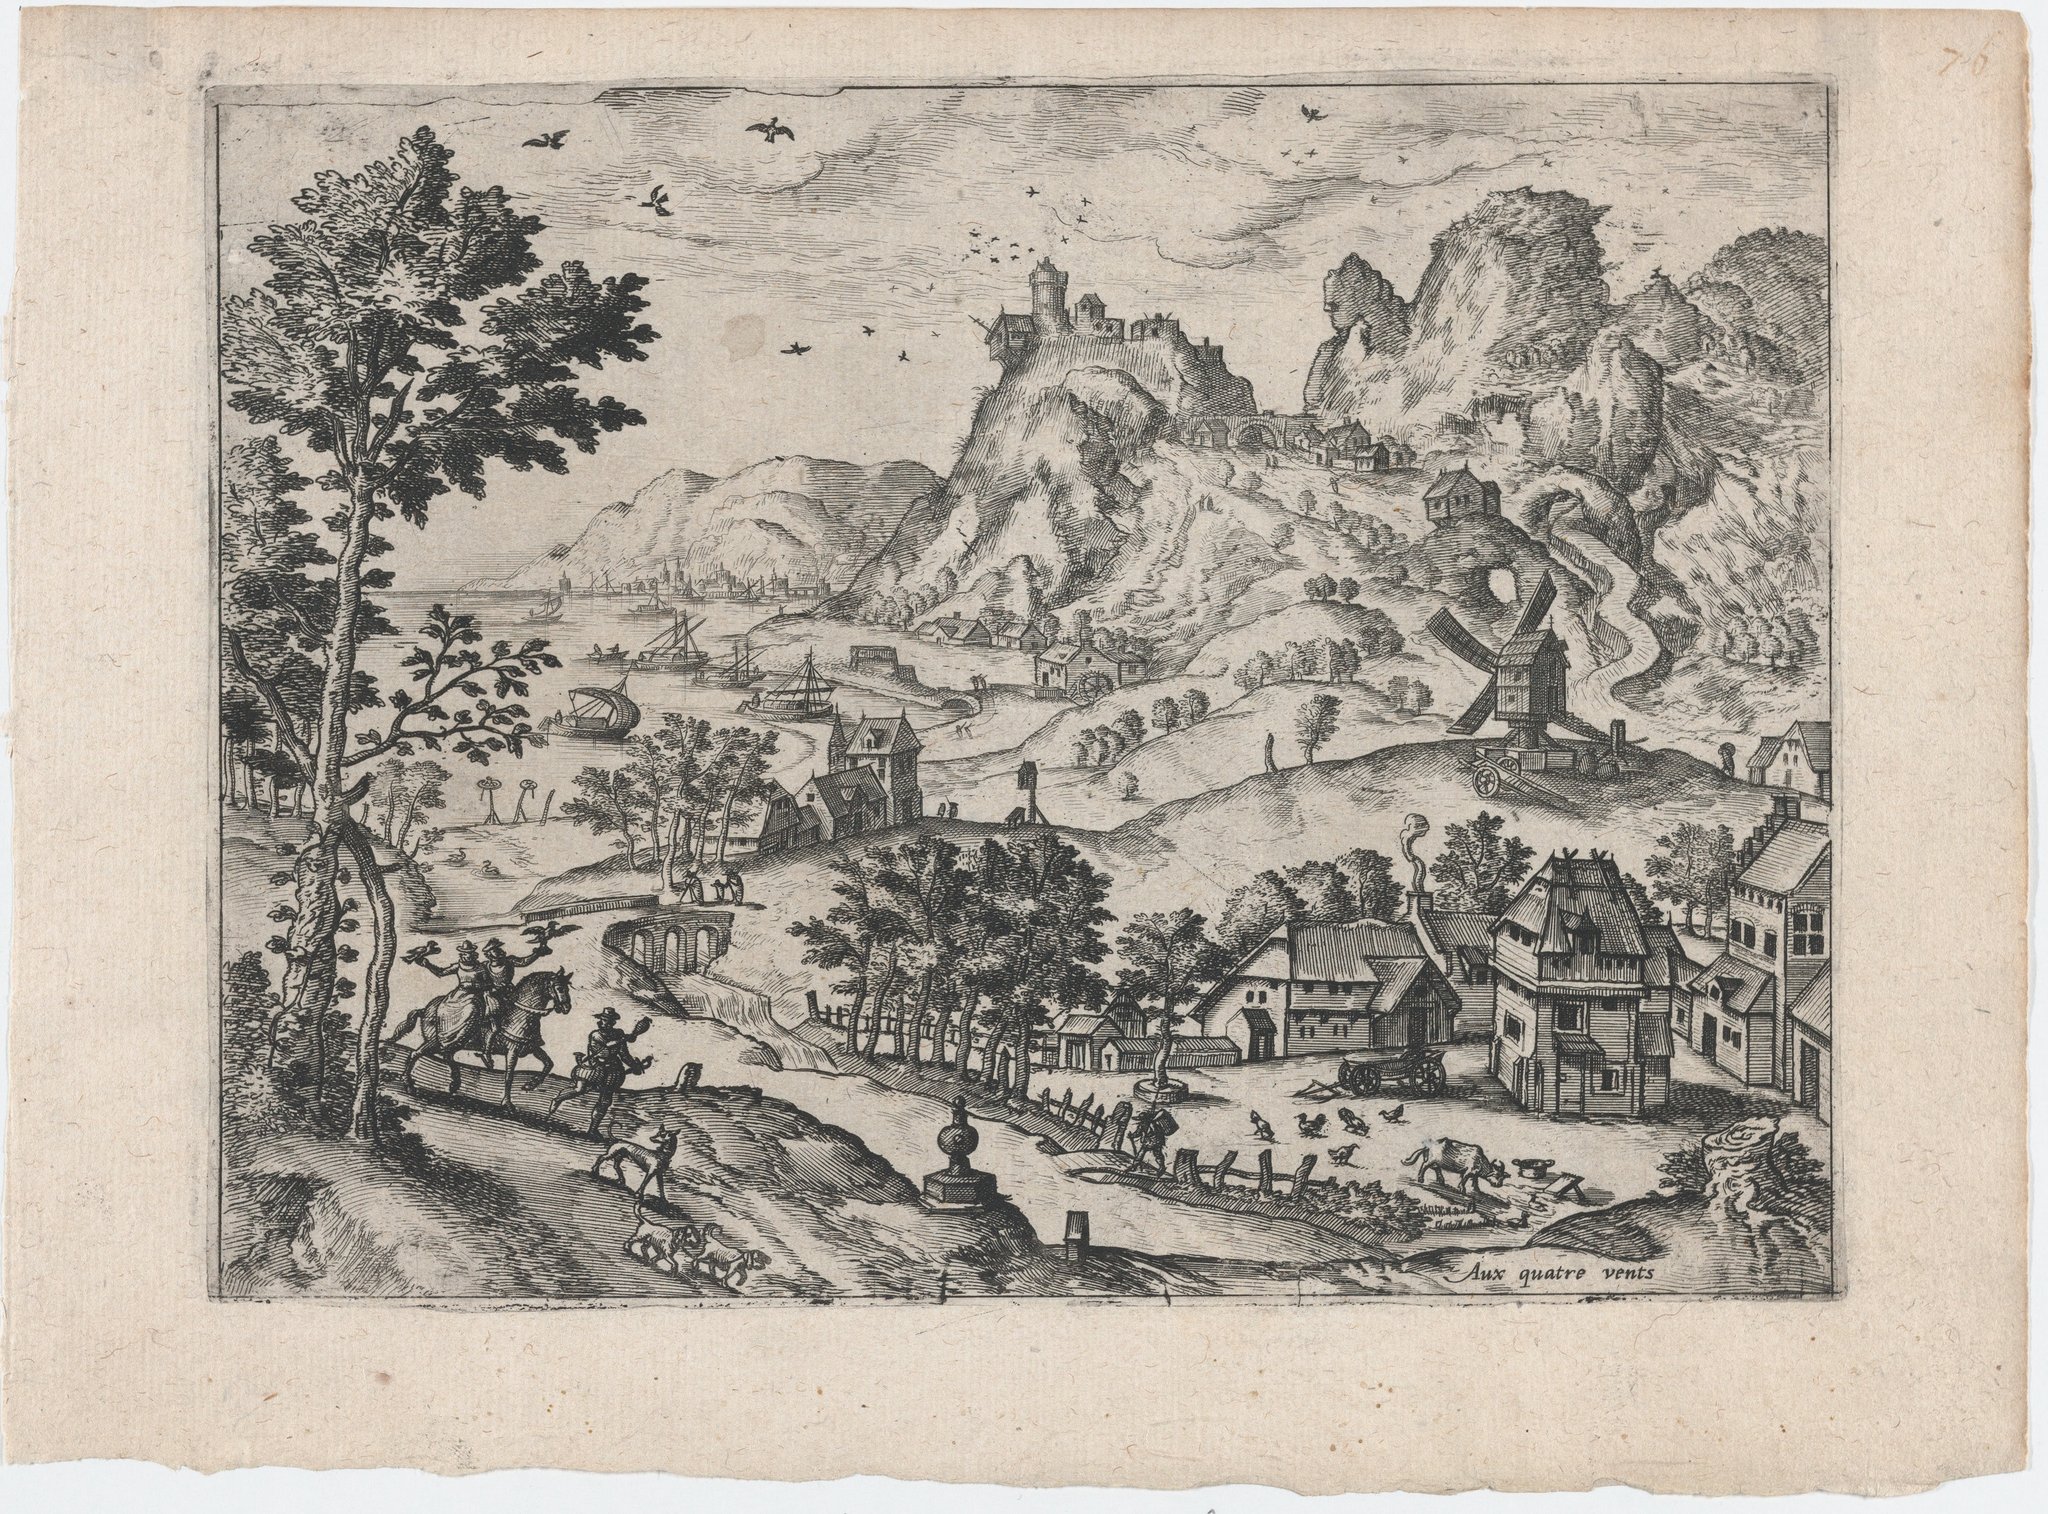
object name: print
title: Mountain Landscape with Falconers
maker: lucas gassel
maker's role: artist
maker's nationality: netherlandish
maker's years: 1495-1500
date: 1560-1570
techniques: engraving, etching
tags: birds,houses,windmills,horses,mountains,landscapes